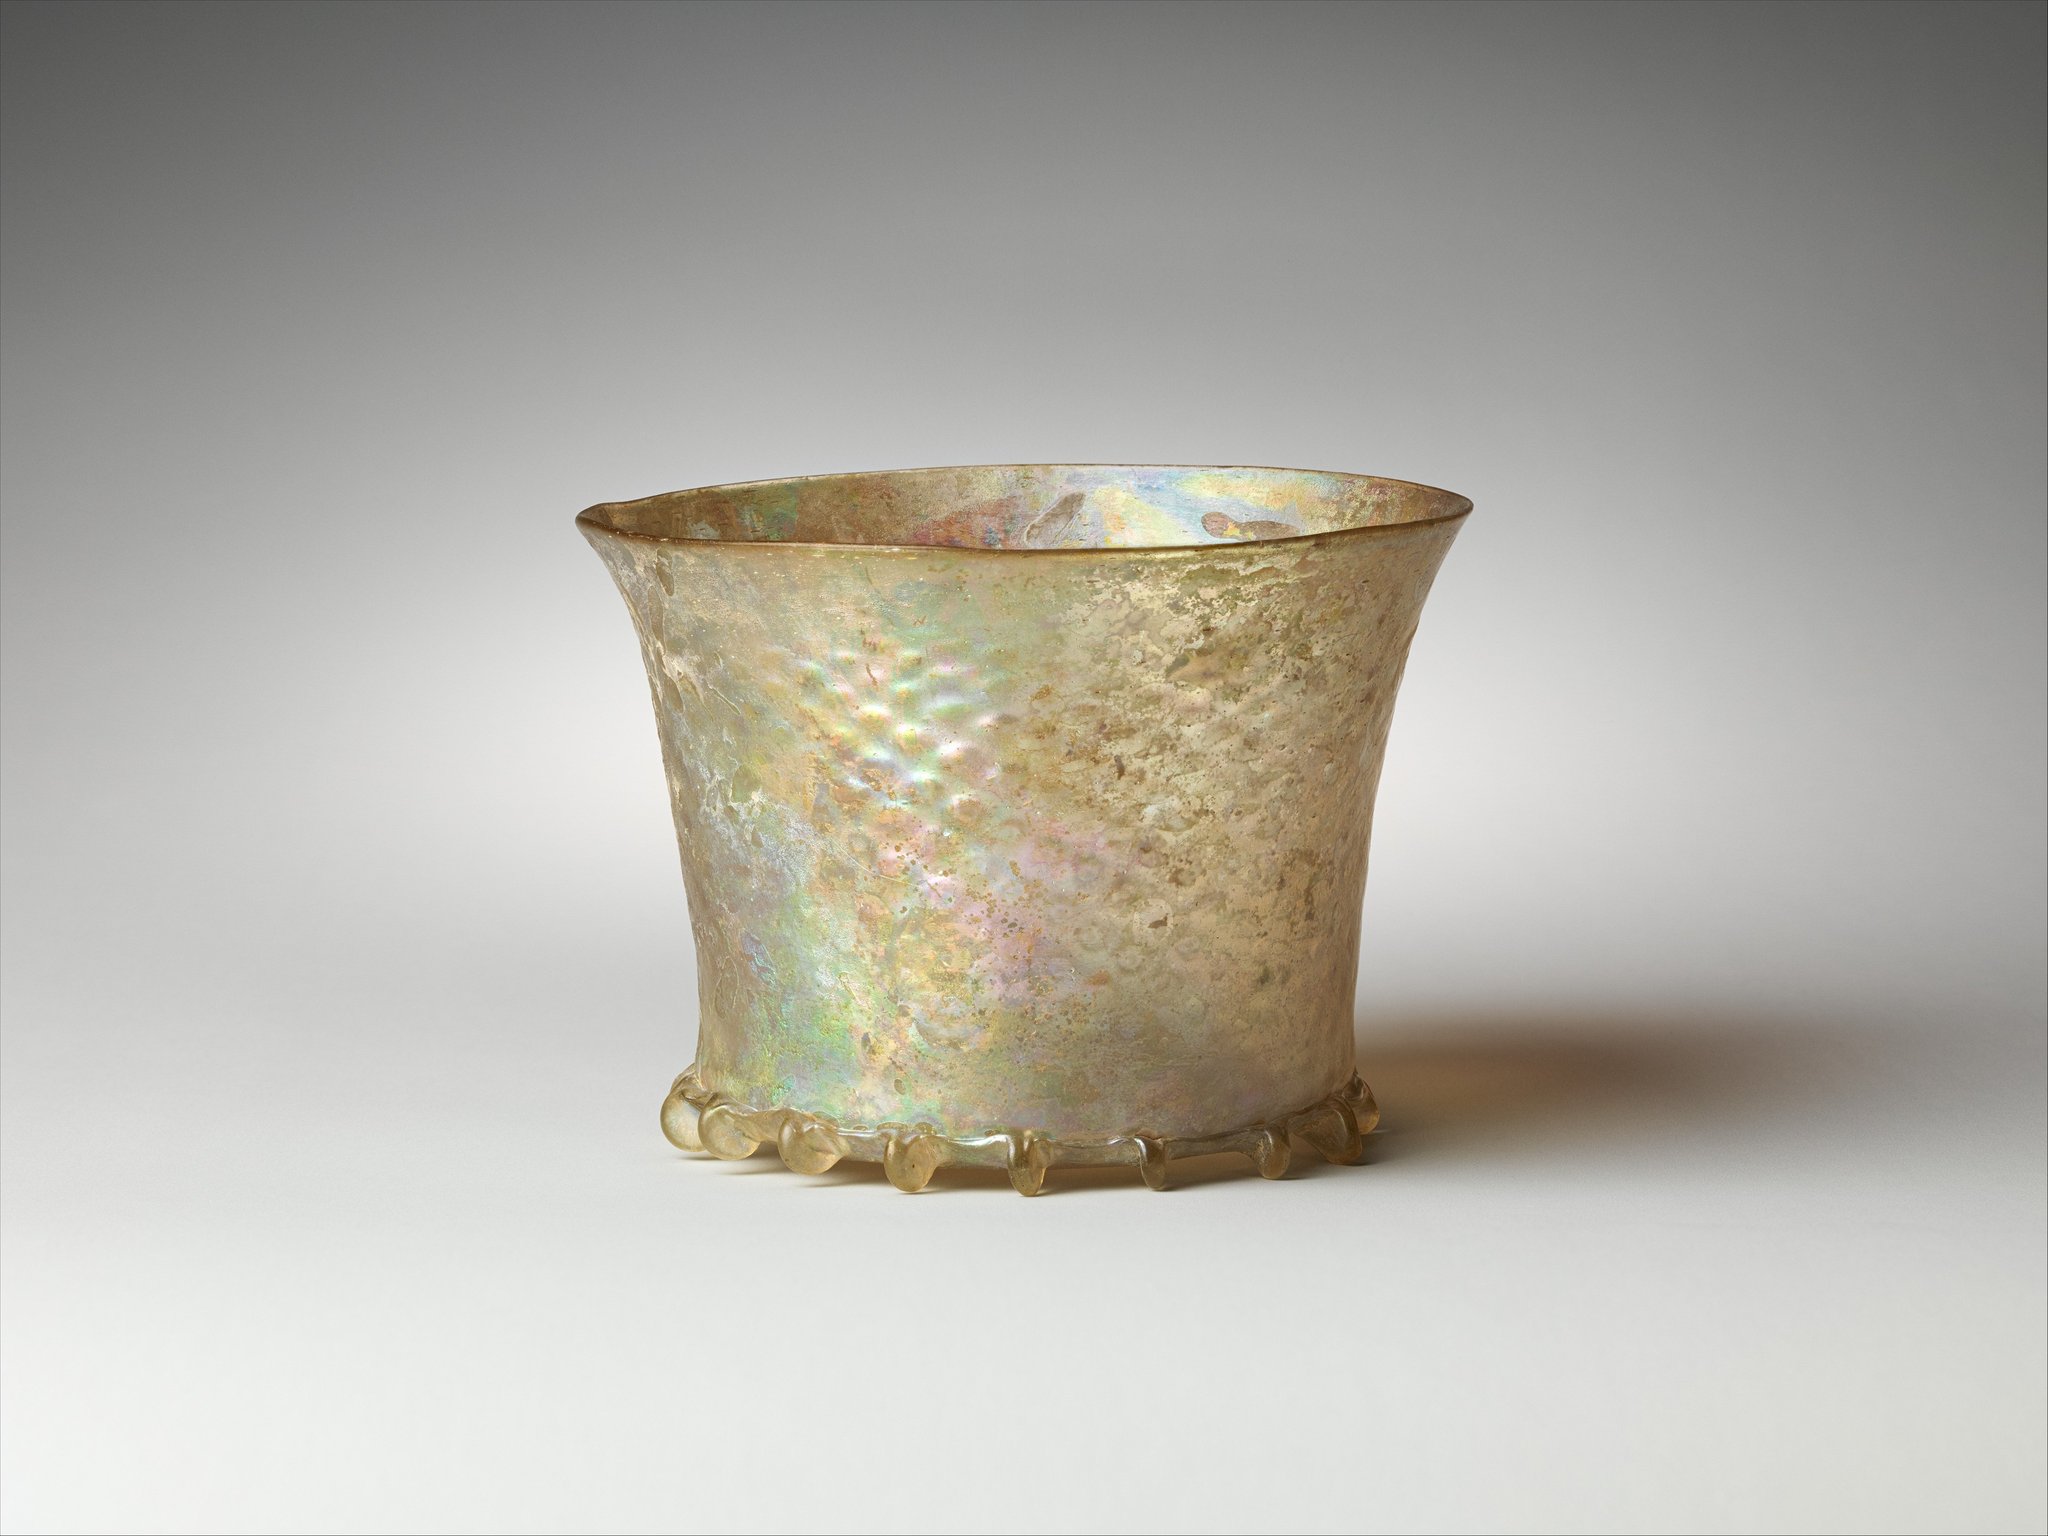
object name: beaker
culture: french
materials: glass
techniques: glassblowing